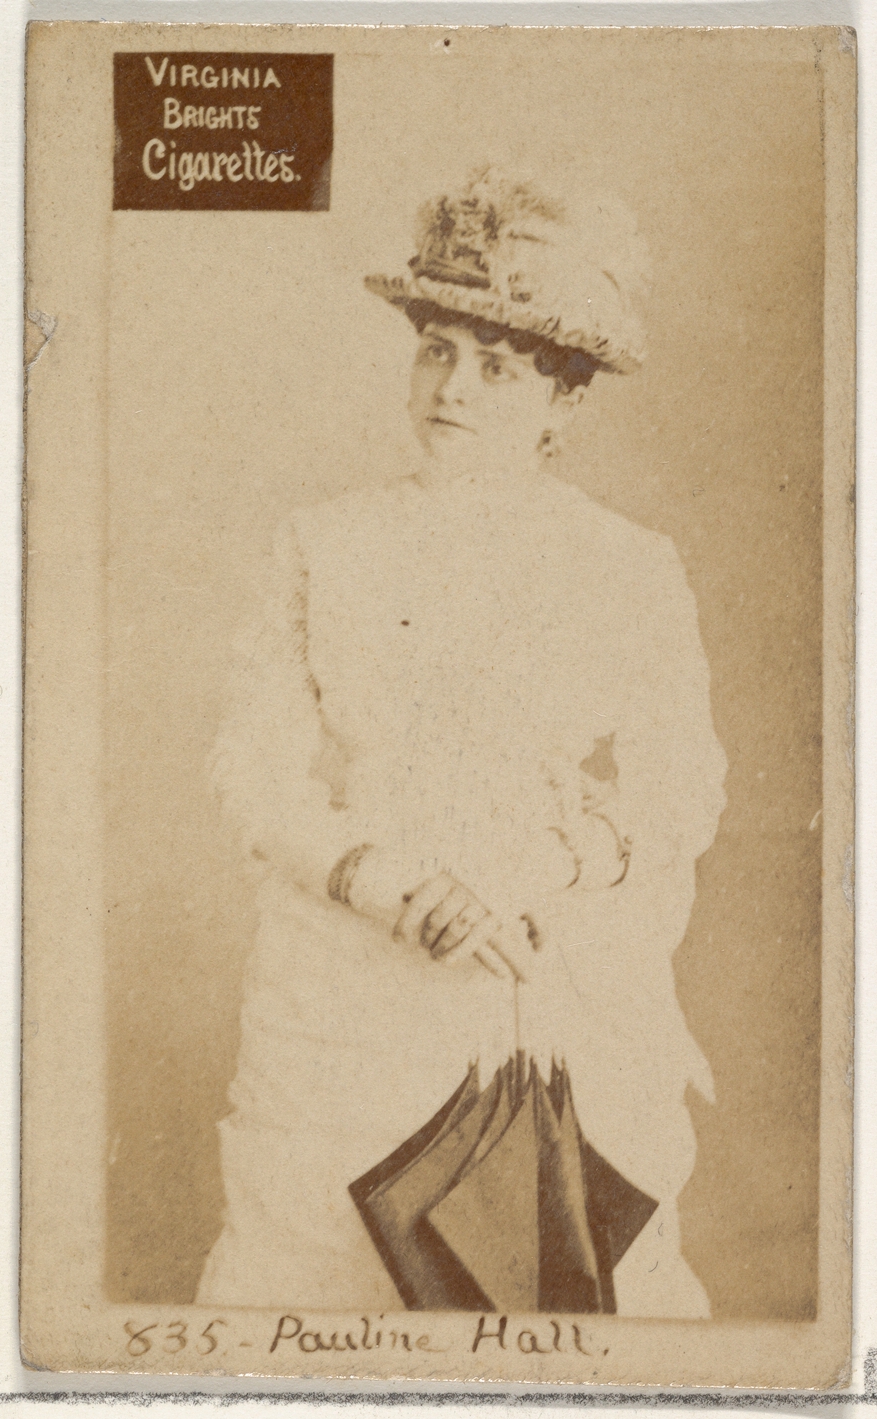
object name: photograph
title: Card 835, Pauline Hall, from the Actors and Actresses series (N45, Type 2) for Virginia Brights Cigarettes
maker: allen & ginter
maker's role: publisher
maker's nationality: american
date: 1888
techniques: albumen silver print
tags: portraits,women,actresses